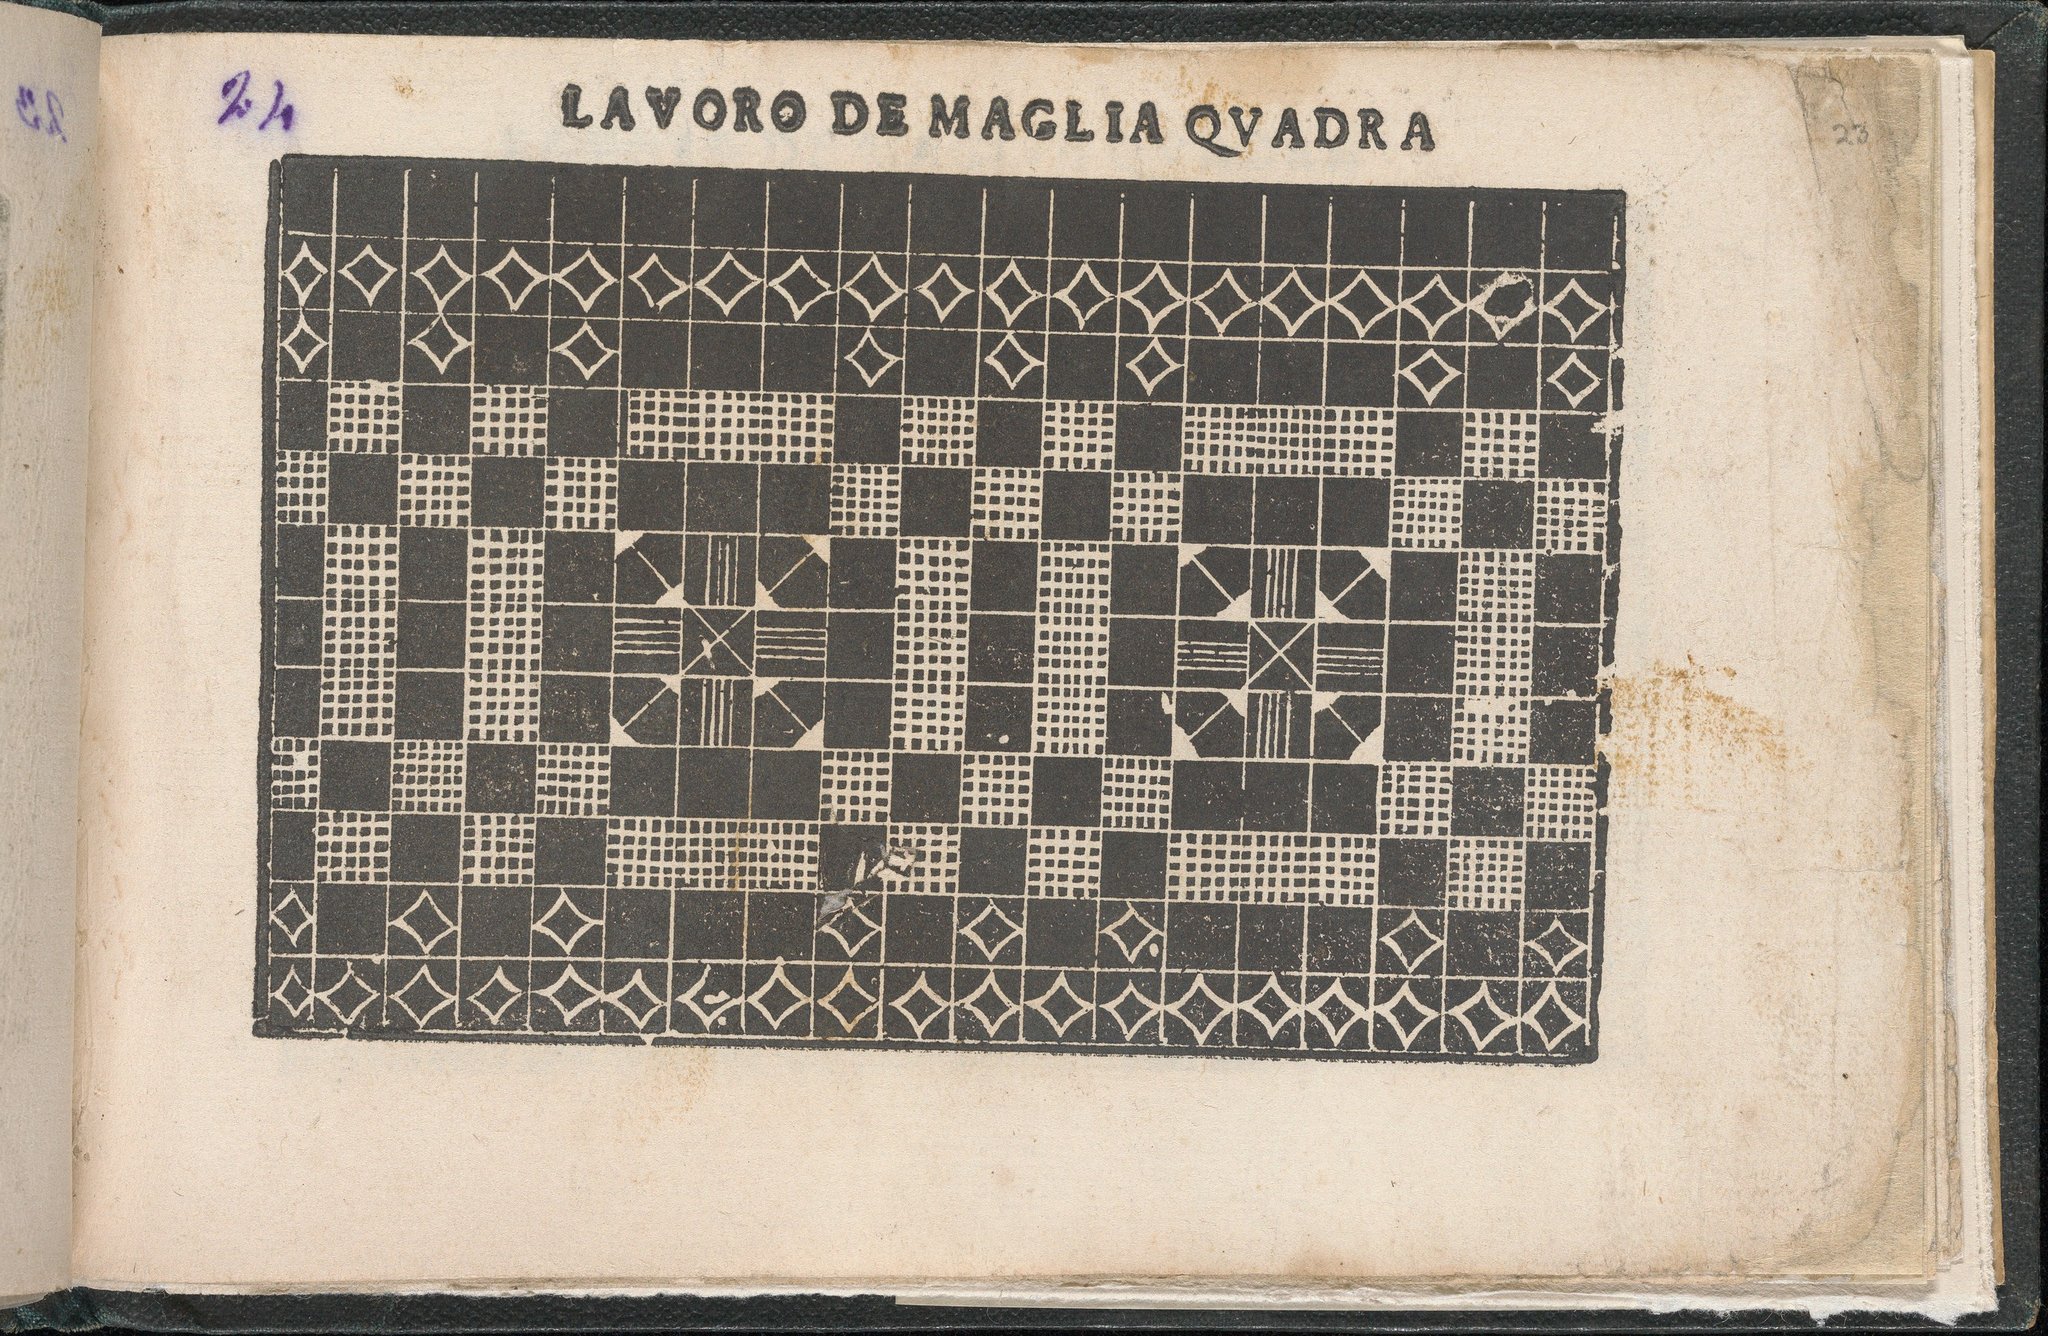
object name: book print ornament architecture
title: Gemma pretiosa della virtuose donne, page 23 (recto)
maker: isabella catanea parasole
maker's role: designer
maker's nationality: italian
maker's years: 1565-1625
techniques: woodcut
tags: ornament